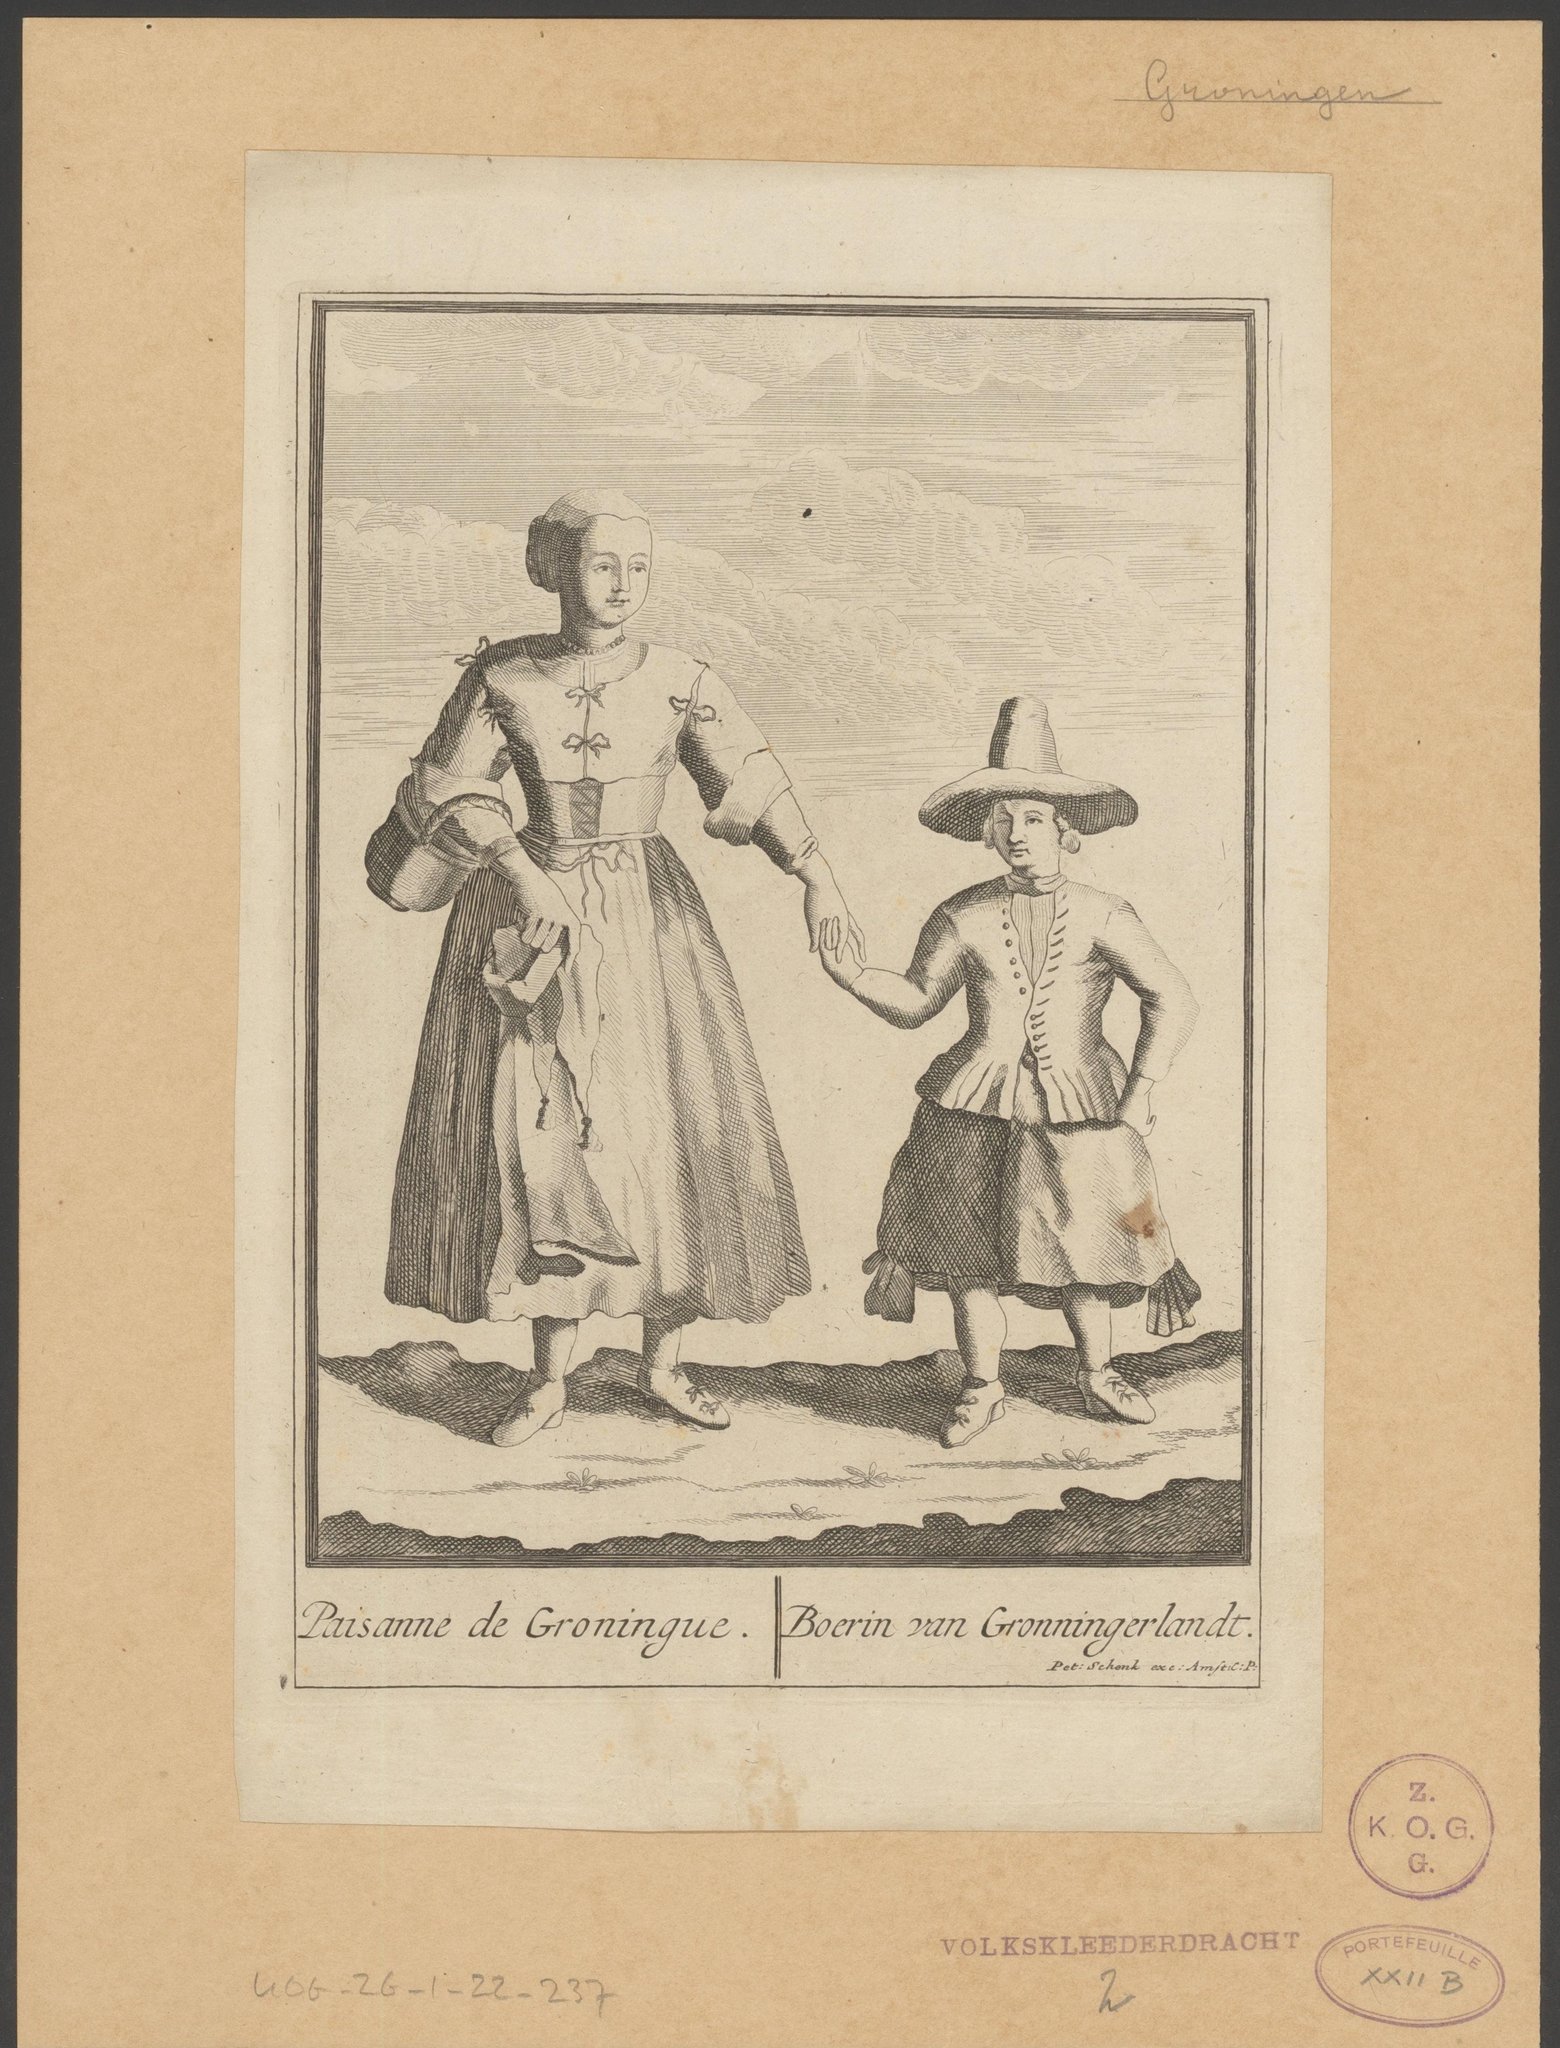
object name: print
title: Boerin van Groningen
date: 1689-1713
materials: paper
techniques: engraving, etching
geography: netherlands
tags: mother and son(s) (family group), clothes, costume (+ children's clothes), farmers - aa - female farmer, farmer's wife, clothes, costume (+ women's clothes), folk costume, regional costume, groningen (province)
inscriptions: collector's mark: Lugt 1641, collector's mark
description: Een boerin uit Groningen, staande met een zoon aan de hand. Ongenummerd. Prent uit een serie prenten naar Pieter van den Berge met dorpelingen die klederdrachten dragen. Onderwerpsrubrieken binnen de Atlas Zeden en Gewoonten: De Kleeding, Volkskleederdracht, Groningen.